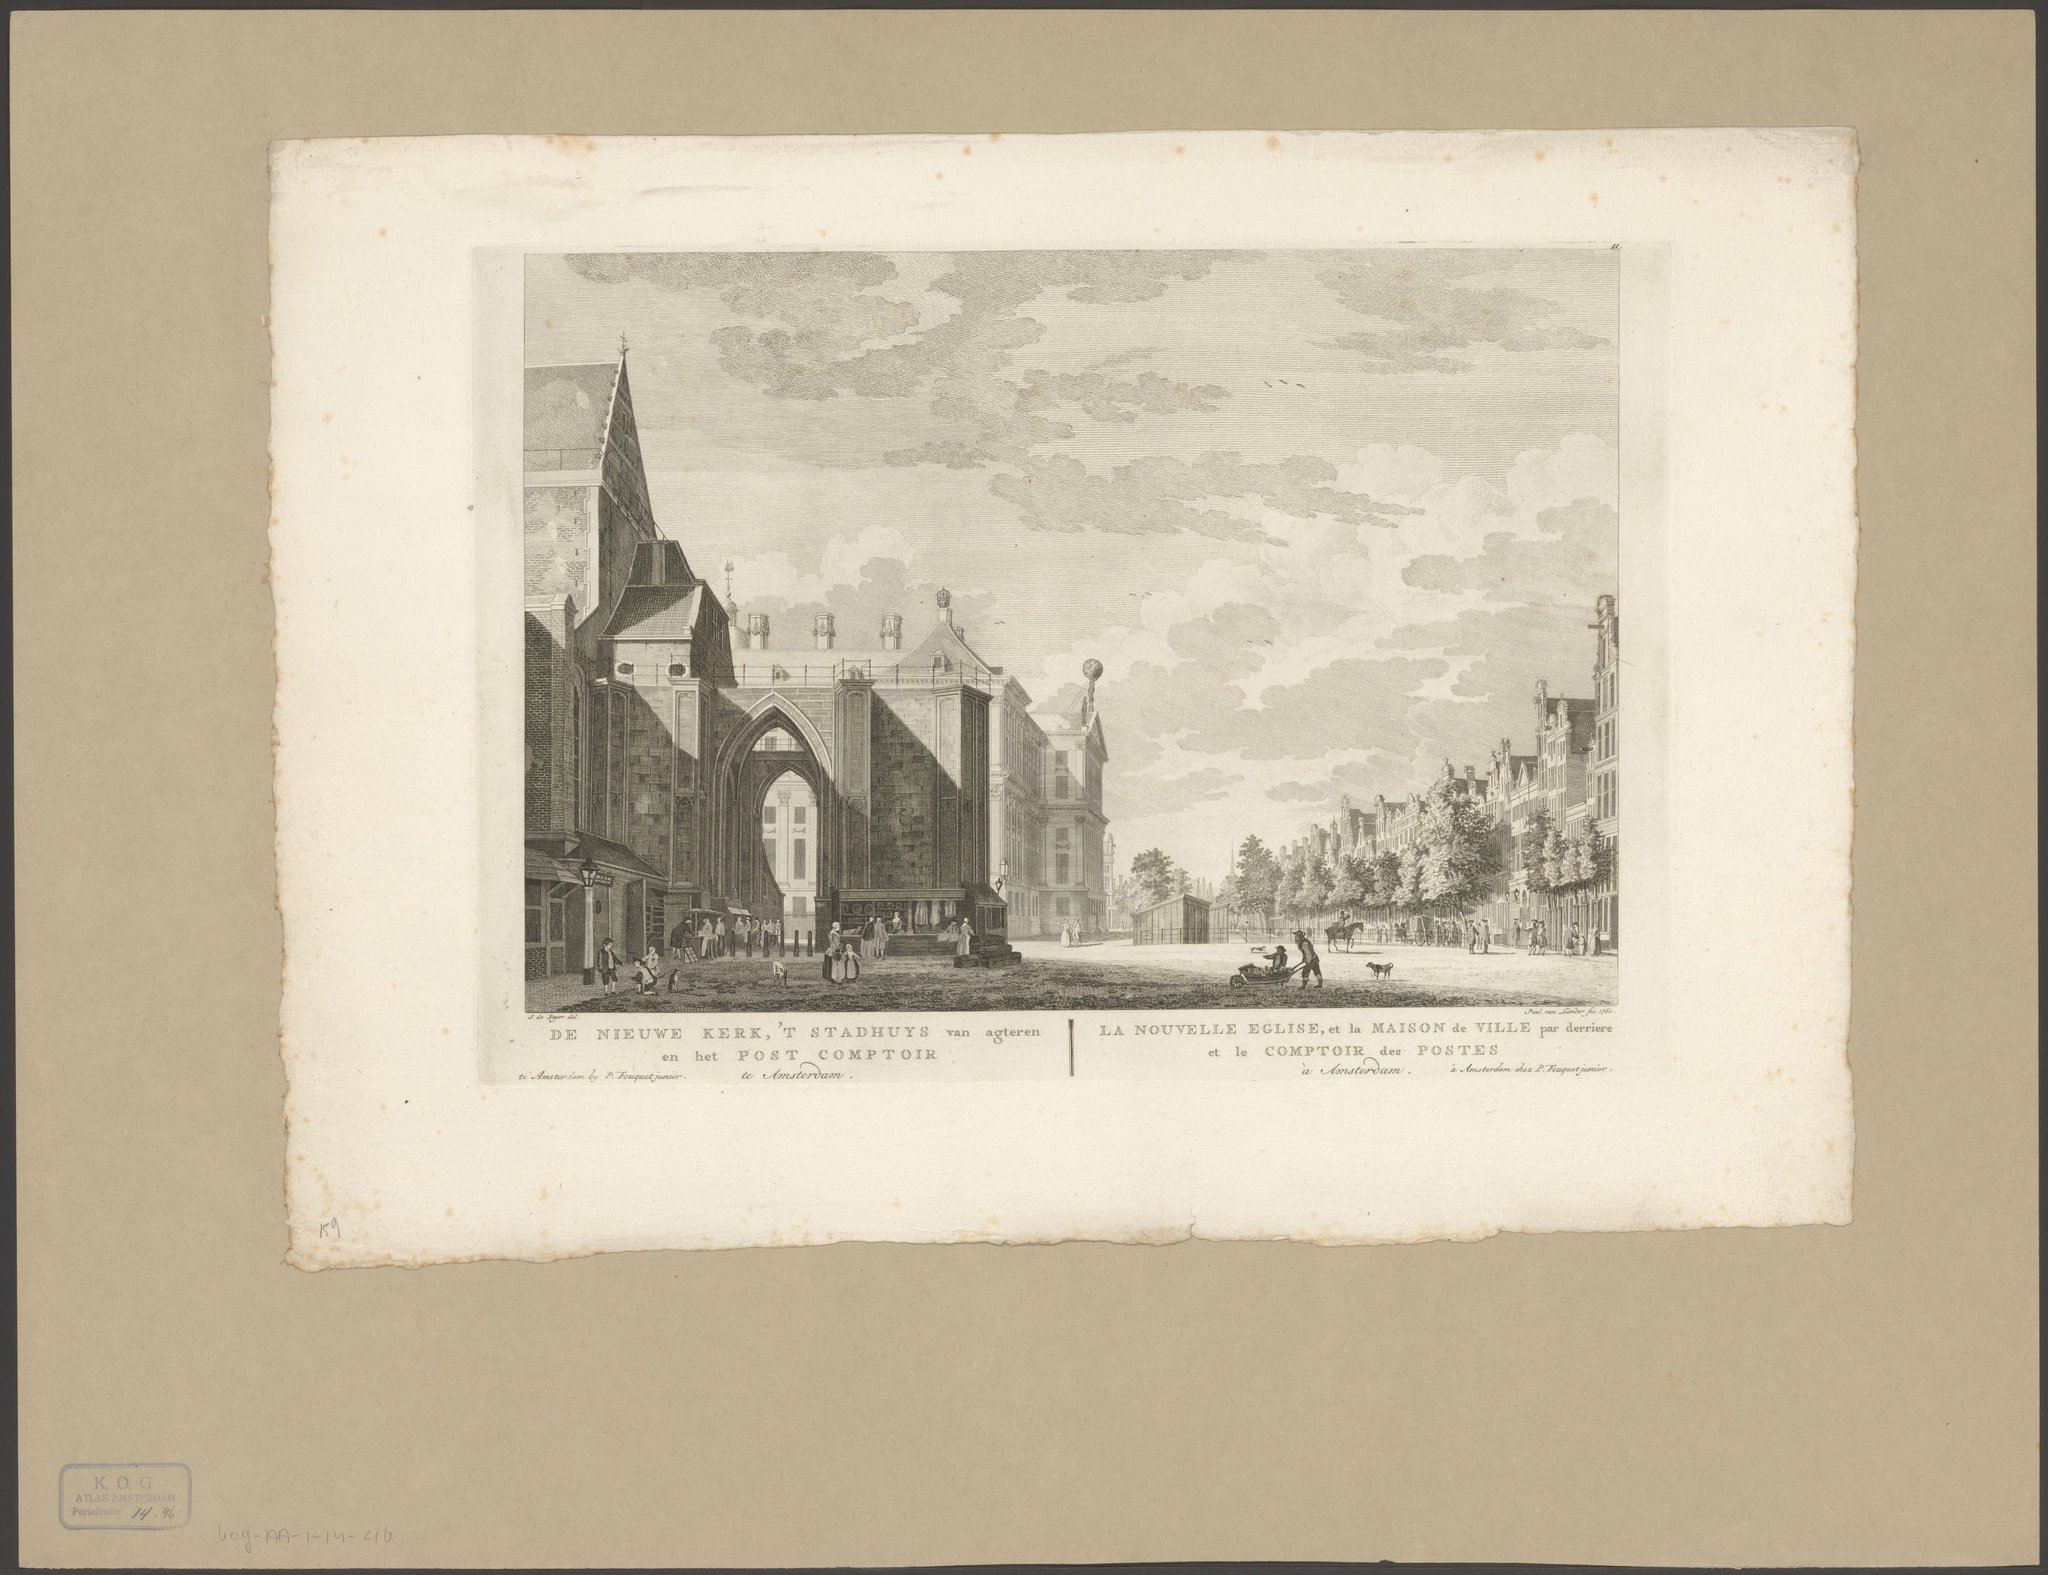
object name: print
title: Gezicht op de Nieuwezijds Voorburgwal met de achterkant van de Nieuwe Kerk en het Stadhuis op de Dam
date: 1788-1801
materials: paper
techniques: etching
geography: amsterdam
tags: post-office, city-view in general; 'veduta', church (exterior), townhall, street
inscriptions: collector's mark: ‘14.46’ Lugt 1641b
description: Deze prent is ook gebruikt in de zogenaamde Atlas van Fouquet.* Pierre Fouquet gaf vanaf 1760 stadsgezichten van Amsterdam - naar tekeningen van verschillende kunstenaars, gemaakt door verschillende prentmakers - uit. Deze prenten werden aanvankelijk los of in series verkocht. Zoals toen gebruikelijk kon de koper de prenten zelf laten inbinden. Hiertoe gaf Fouquet tussen 1778 en 1783 een titelblad, plattegrond en inhoudsopgave van de tot dusver 100 uitgegeven prenten uit (1). Gezien de inhoud afhankelijk was van wat de koper had verzameld verschilt de inhoud van de verschillende bewaarde Fouquetatlassen onder deze titel sterk. Ook zijn er exemplaren bekend waar tevens andere prenten aan zijn toegevoegd. Omdat er behoefte bleek aan uitleg bij de platen werd in 1783 een nieuwe versie van de atlas uitgegeven, aangevuld met tekst en twee prenten. De aangegeven volgorde veranderde maar de platen van de al eerder uitgegeven prenten bleven ongewijzigd. Deze uitgave werd in opdracht van Fouquet gedrukt bij Daniël Jean Changuion en Petrus den Hengst (2). Een tiental platen werd bijgewerkt en verscheen, met nieuw impressum, in het vervolg van Wagenaars geschiedenis van Amsterdam, uitgeven door Petrus Conradi en Folkert van der Plaats (3). Een aantal jaar na het overlijden van Fouquet kwam Evert Maaskamp met een nieuwe uitgave van de atlas, met verbeterde tekst en toevoeging van twee prenten. Op alle platen verwijderde hij het oude en liet hij zijn eigen impressum zetten (4). De huidige staat van de prent komt voor in exemplaren van de onder (3) genoemde werken. * Onder de Atlas van Fouquet of Fouquetatlas verstaan we de hieronder vermelde publicaties (1), (2) en (4). (1). Afbeeldingen van de wyd-vermaarde koopstad Amsterdam benevens des zelvs voornaamste gebouwen en gezigten alle naar het leeven getekend / Receuil des edifices les plus considerables et des plus belles vues, de la fameuse ville d'Amsterdam, dessinées d'après nature. Amsterdam: Pierre Fouquet, 1778-1783. (2). Nieuwe atlas, van de voornaamste gebouwen en gezigten der stad Amsterdam, met derzelver beknopte beschryvingen. 2 delen. Amsterdam: Daniël Jean Changuion en Petrus den Hengst [in opdracht van Pierre Fouquet], 1783. (3). Stijl, Simon. Amsterdam, in zyne geschiedenissen, voorregten, koophandel, gebouwen, kerkenstaat, schoolen, schutterye, gilden en regeeringe, beschreeven. Om te dienen ten vervolge op het werk van Jan Wagenaar (…). 10 delen. Amsterdam en Harlingen: Petrus Conradi en Folkert van der Plaats, 1788-1801. (4). Nieuwe atlas, van de voornaamste gebouwen en gezigten der stad Amsterdam. Met derzelver beknopte beschryvingen. Amsterdam: Evert Maaskamp, 1805. * Het aantal vermelde staten is gebaseerd op het aantal gevonden staten. Mogelijk zijn er meer staten van deze prent. Voor eerste bekende staat zie RP-P-AO-21-29 en tweede bekende staat RP-P-OB-46.347.